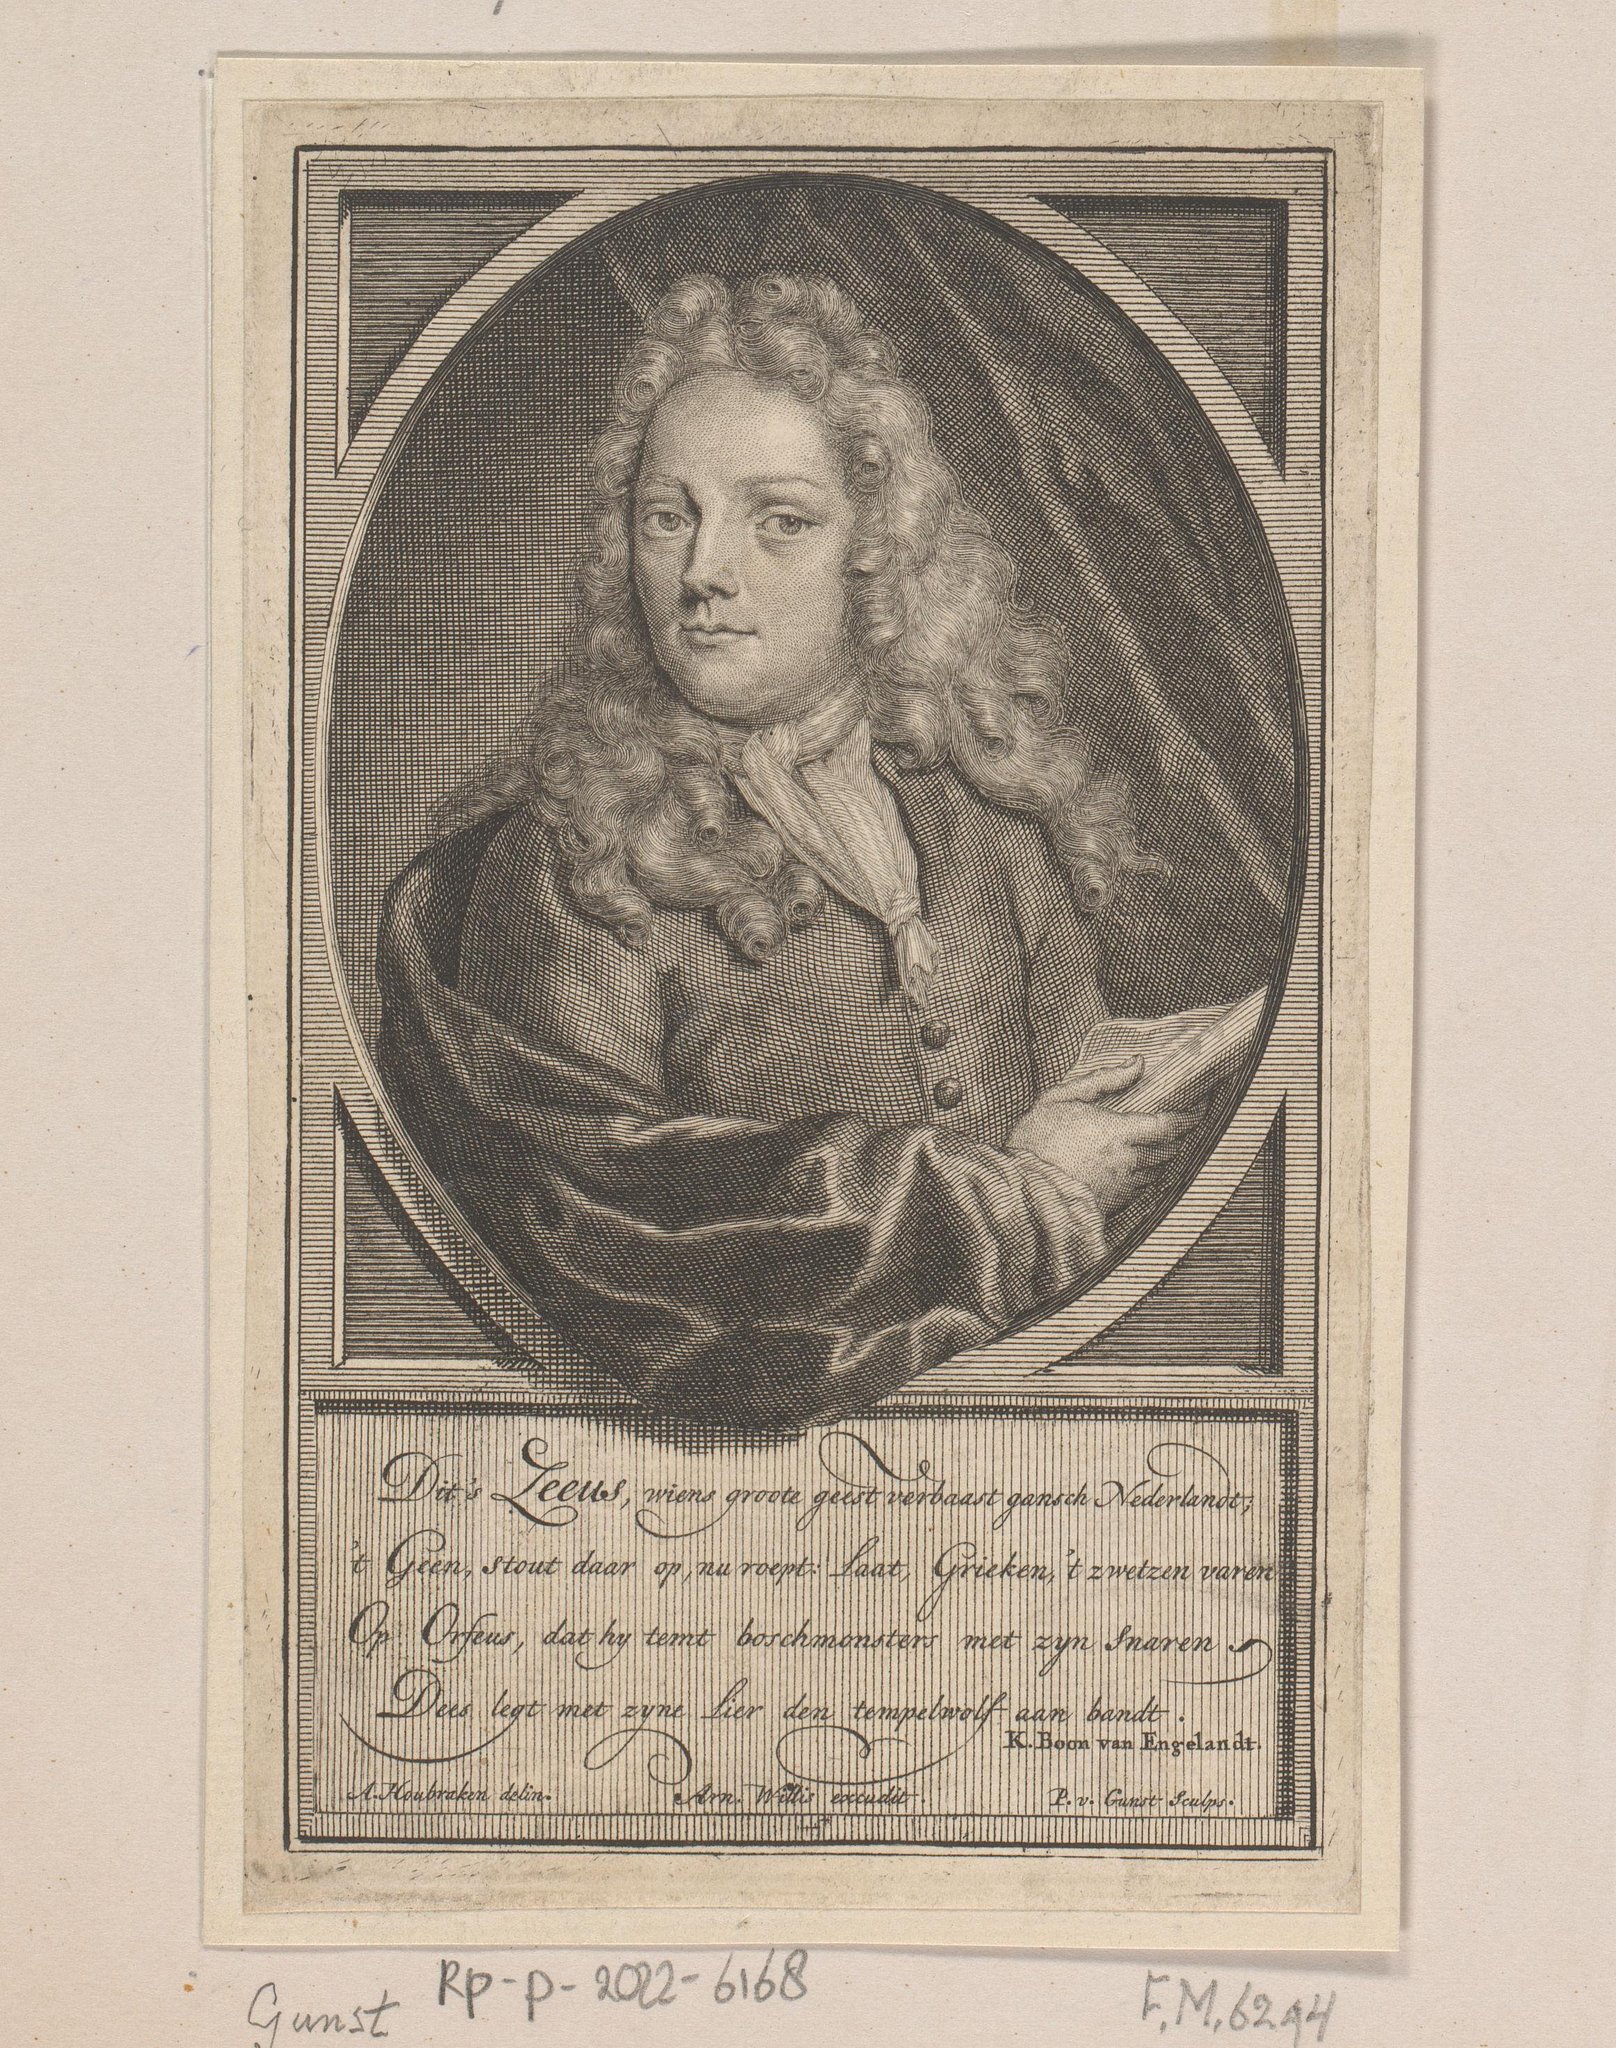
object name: print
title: Portret van Jakop Zeeus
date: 1696-1731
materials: paper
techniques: engraving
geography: rotterdam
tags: jakob zeeus, historical persons, portrait of a writer, notary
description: Met vierregelig vers in het Nederlands als onderschrift.